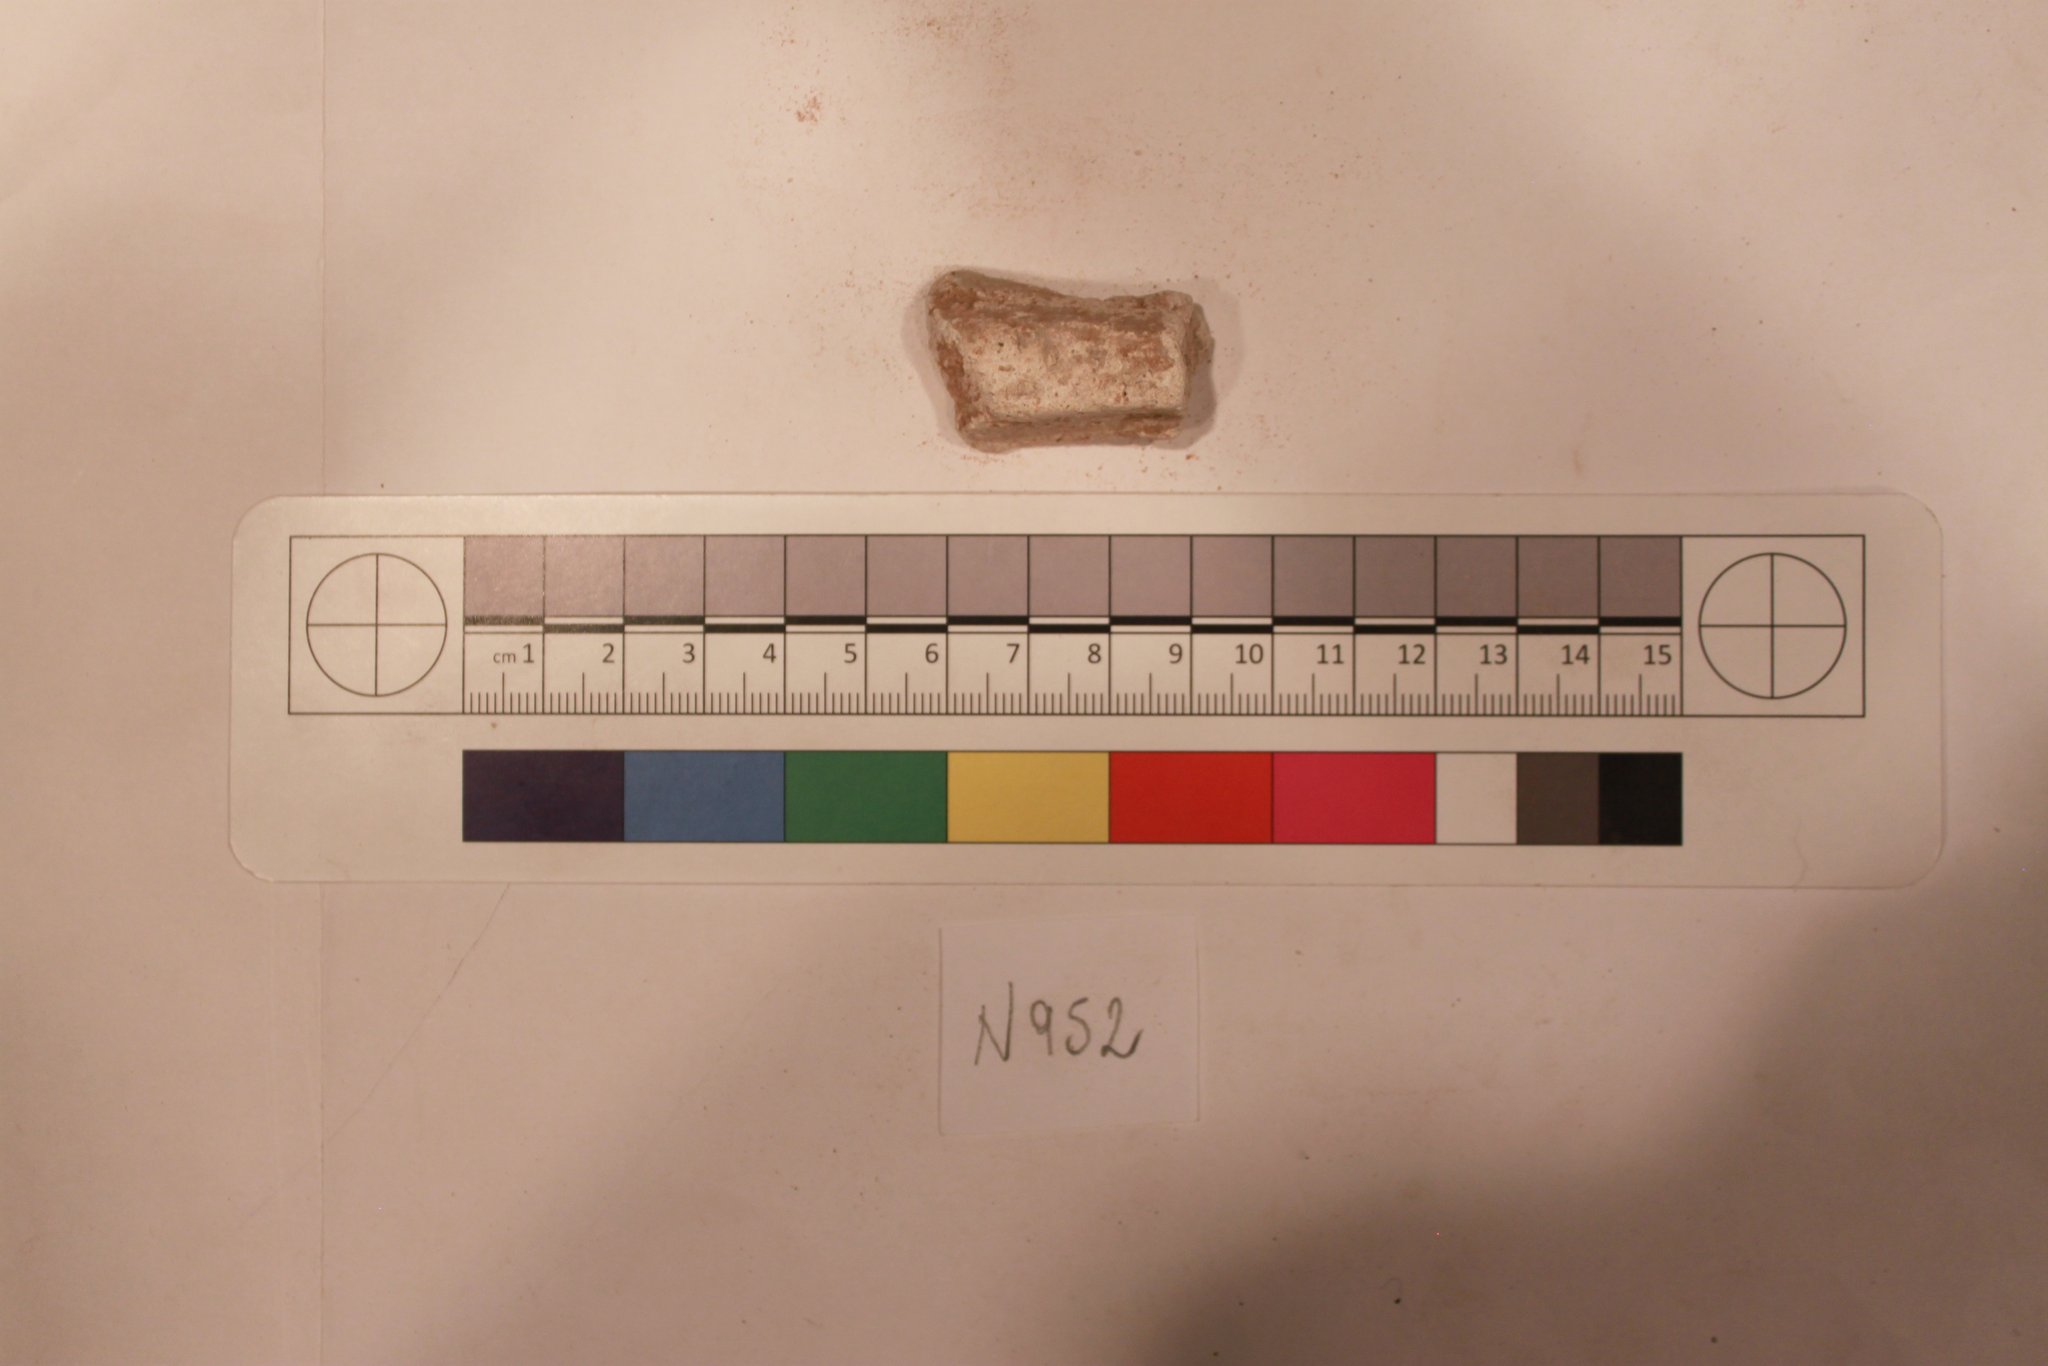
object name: fragment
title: Stucco Fragment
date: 701-1200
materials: plaster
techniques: carving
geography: iran